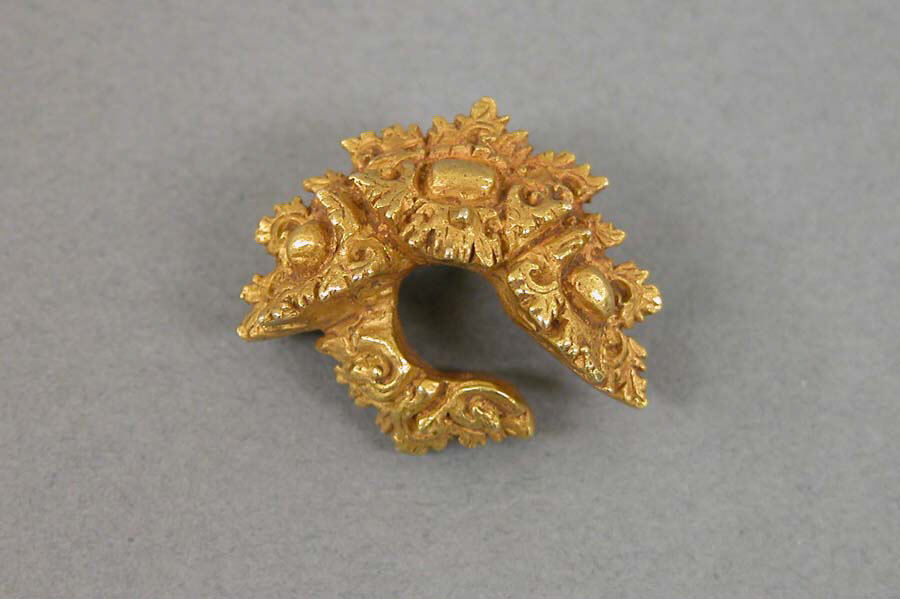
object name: ornament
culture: indonesian, javanese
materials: gold